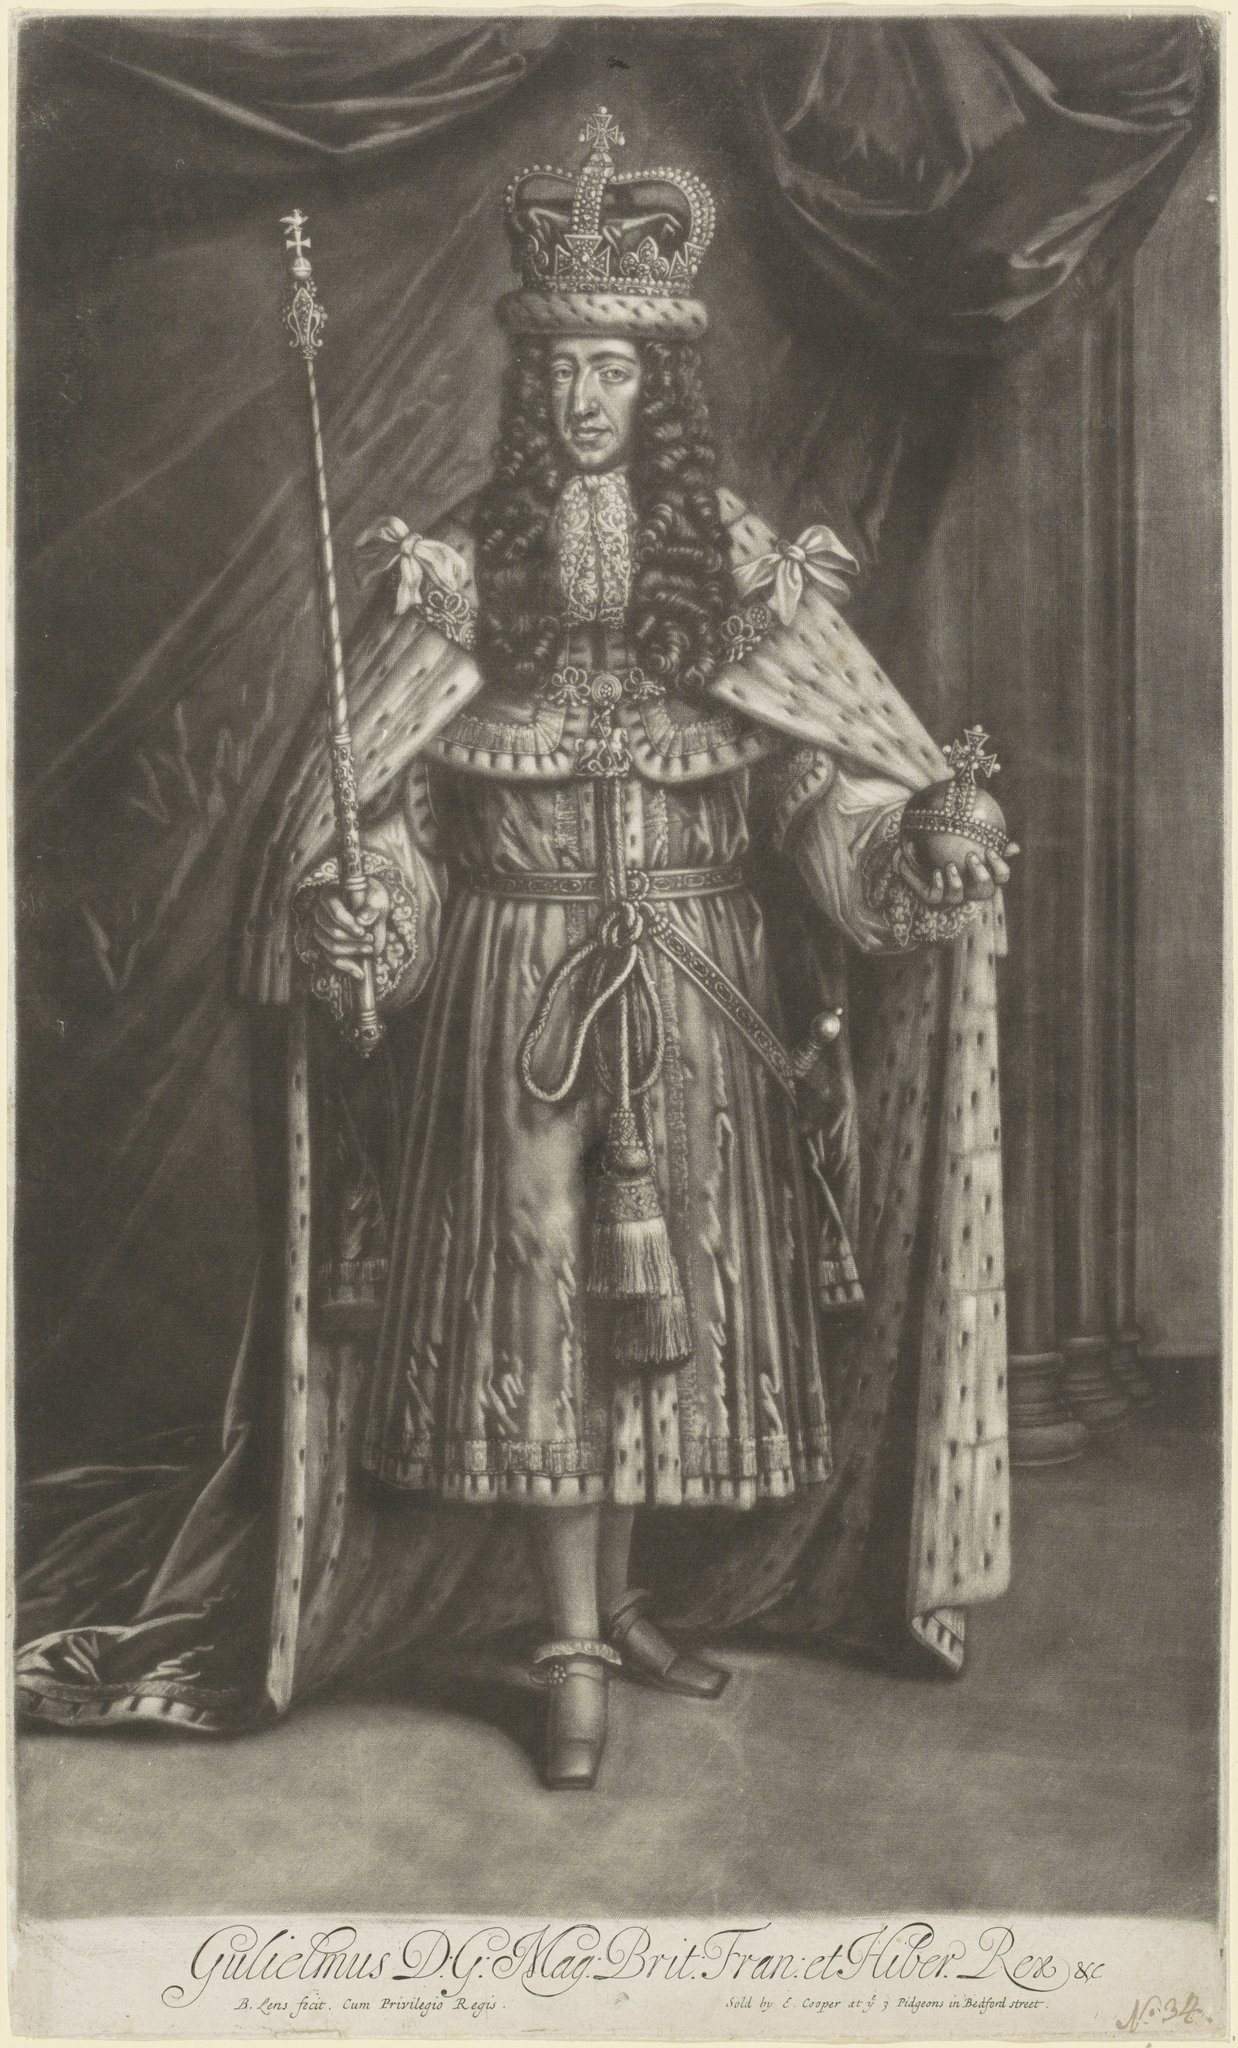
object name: print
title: Portret van Willem III, prins van Oranje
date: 1688-1725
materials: paper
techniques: mezzotint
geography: england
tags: the hague, william iii (prince of orange and king of england, scotland, and ireland), knighthood order (garter) - insignia of a knighthood order, e.g.: badge, chain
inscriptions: collector's mark: Lugt 963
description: Portret van Willem III met een kroon. Hij staat in een vertrek met in zijn rechterhand een scepter en in zijn linkerhand de rijksappel. In de ondermarge zijn naam en titels.